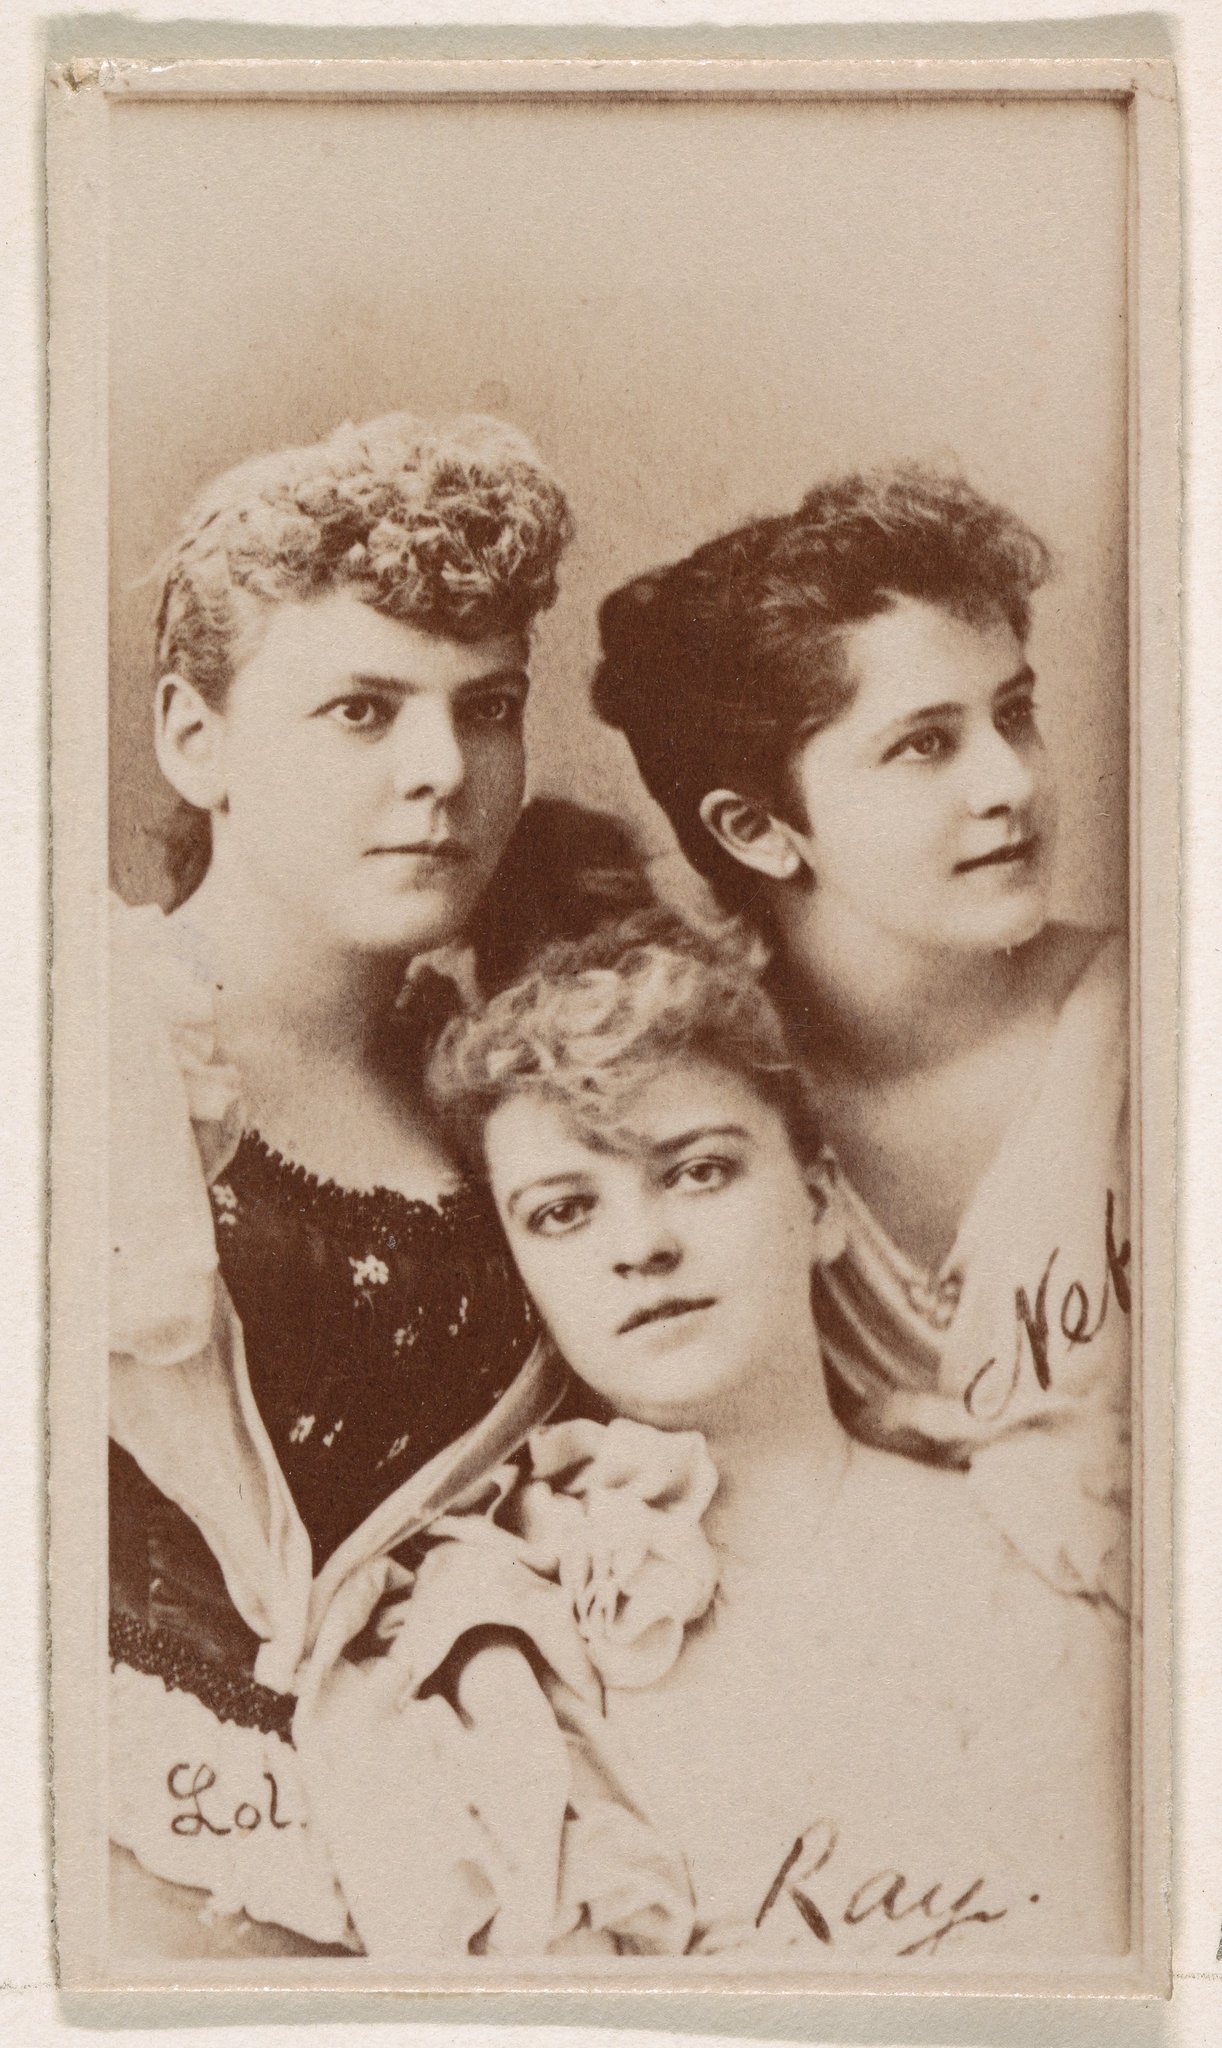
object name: photograph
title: Three actresses, from the Actresses series (N245) issued by Kinney Brothers to promote Sweet Caporal Cigarettes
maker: kinney brothers tobacco company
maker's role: publisher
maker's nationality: american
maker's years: 1869-2011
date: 1890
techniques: albumen silver print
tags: portraits,women,actresses